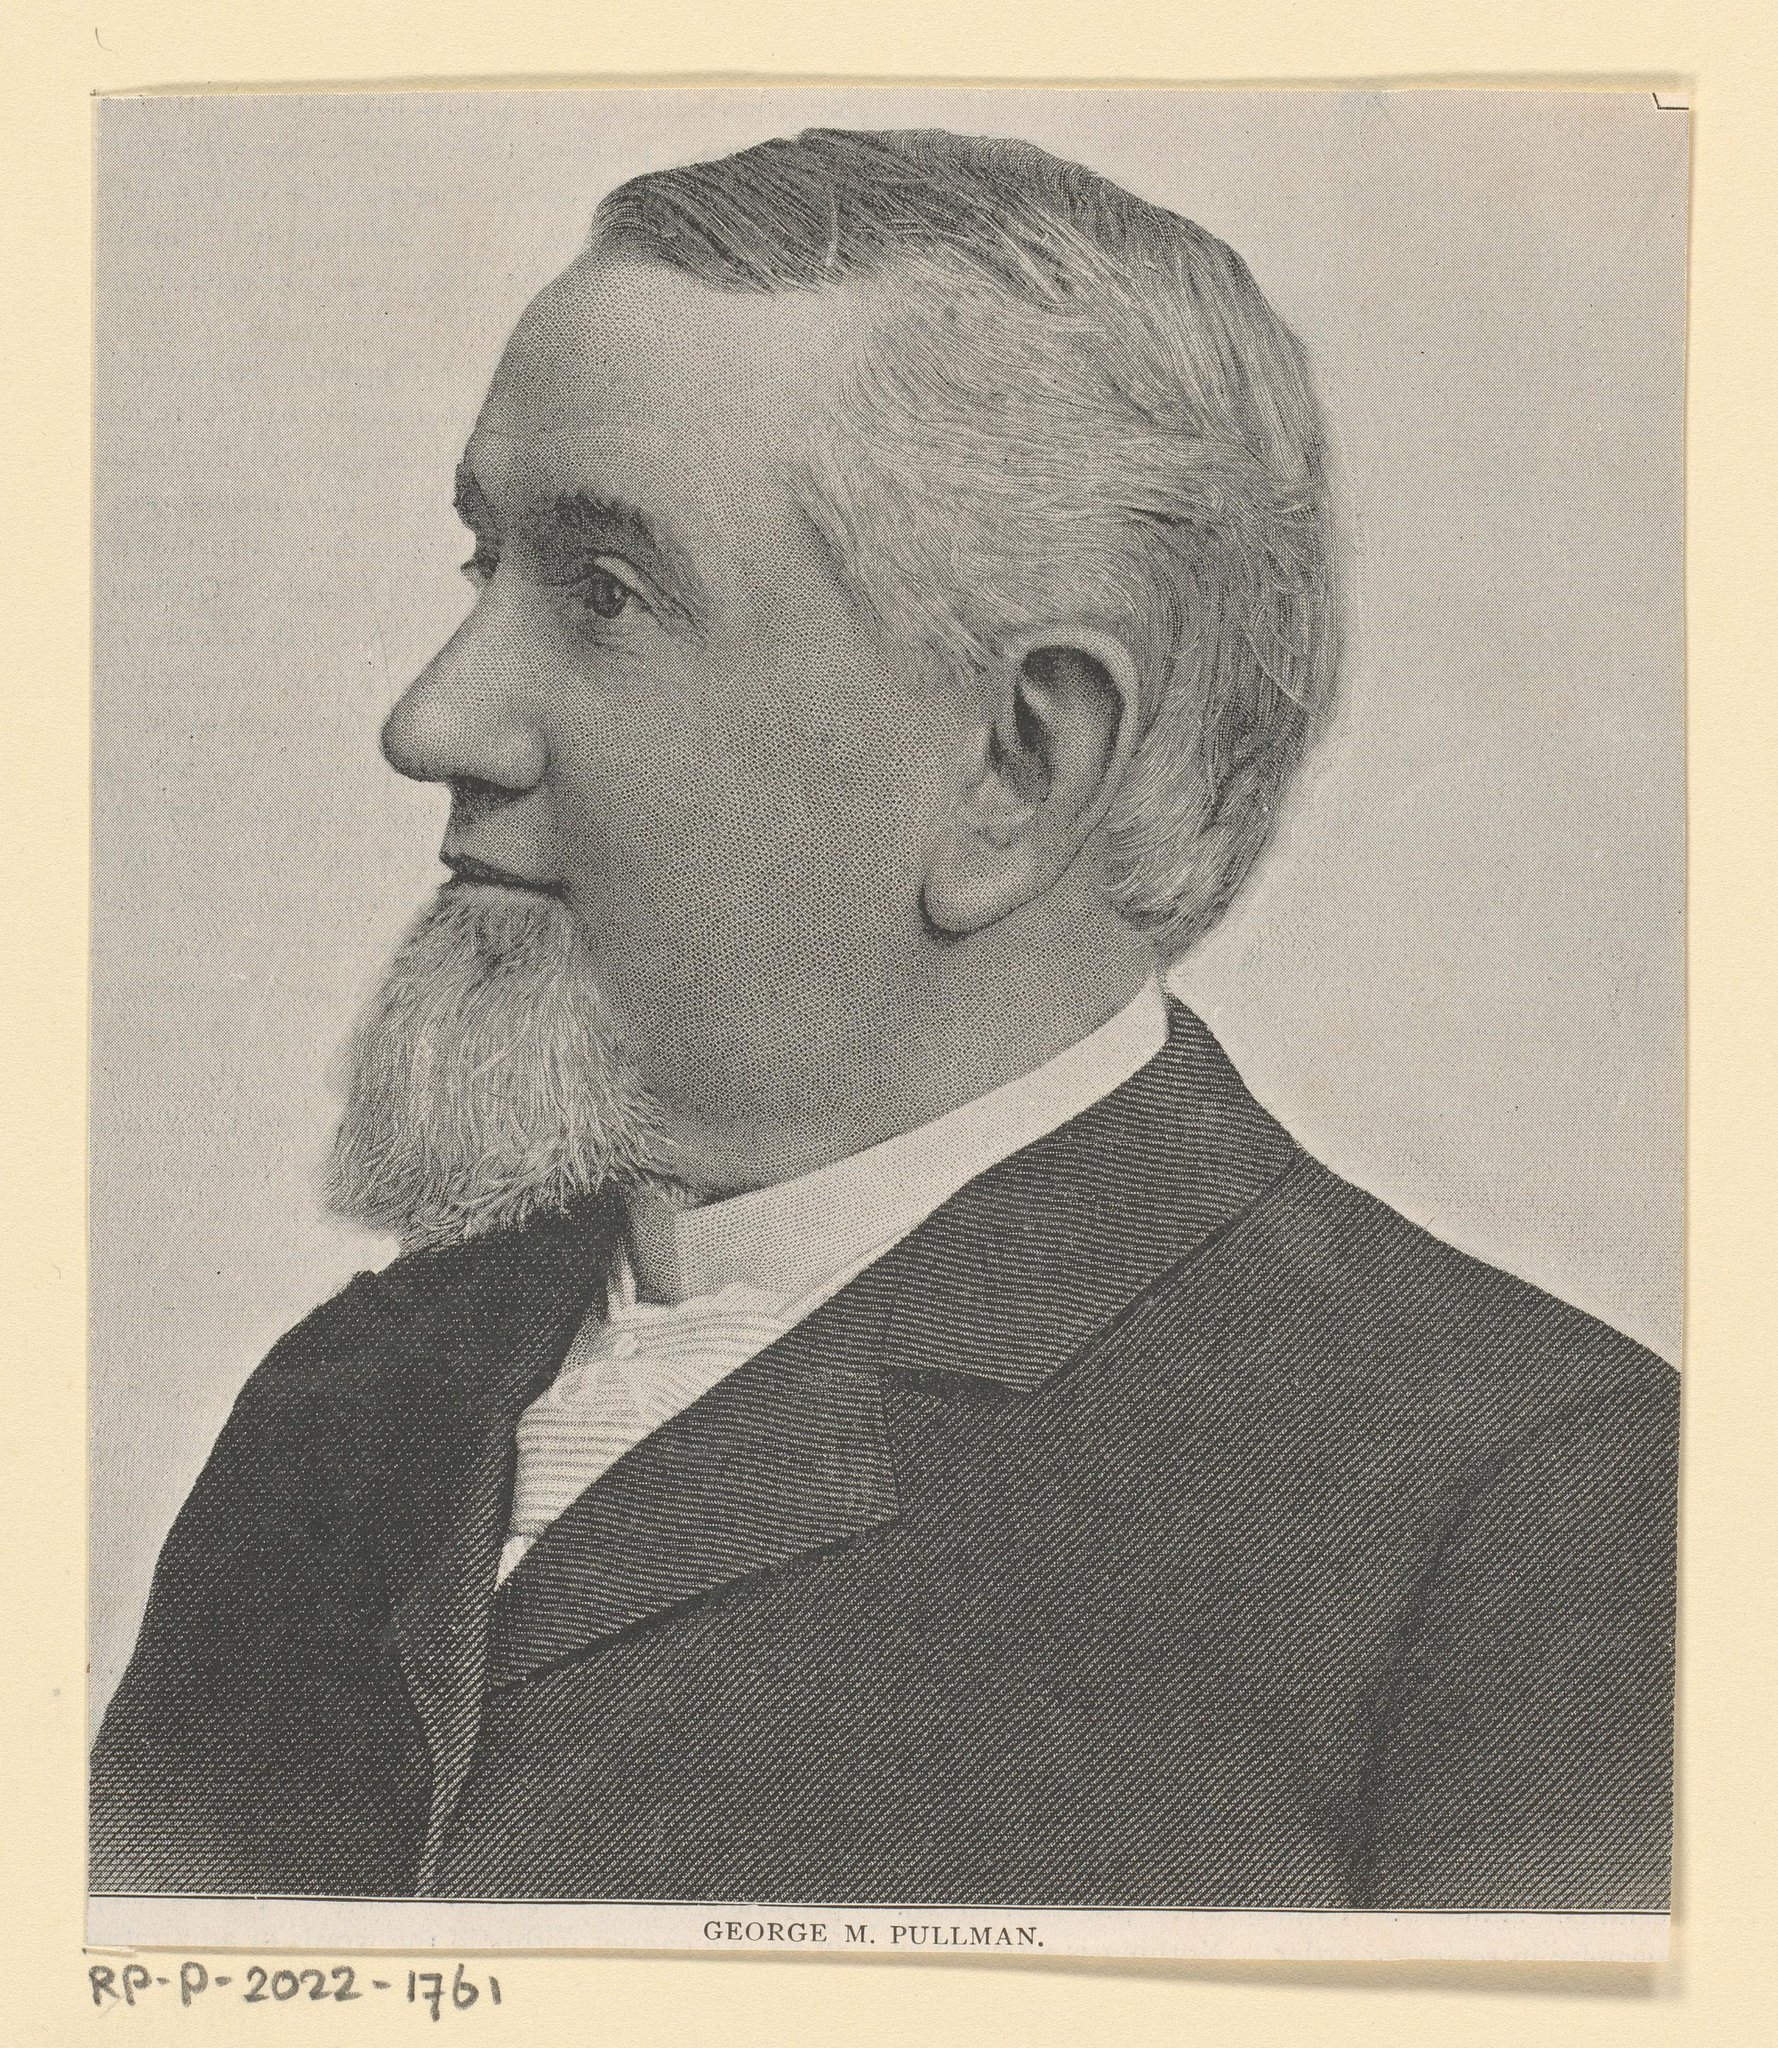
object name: photomechanical print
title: Portret van George Pullman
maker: Anonymous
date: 1882-1970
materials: paper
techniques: letterpress printing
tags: historical persons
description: Fotomechanische afdruk uit een onbekende publicatie.